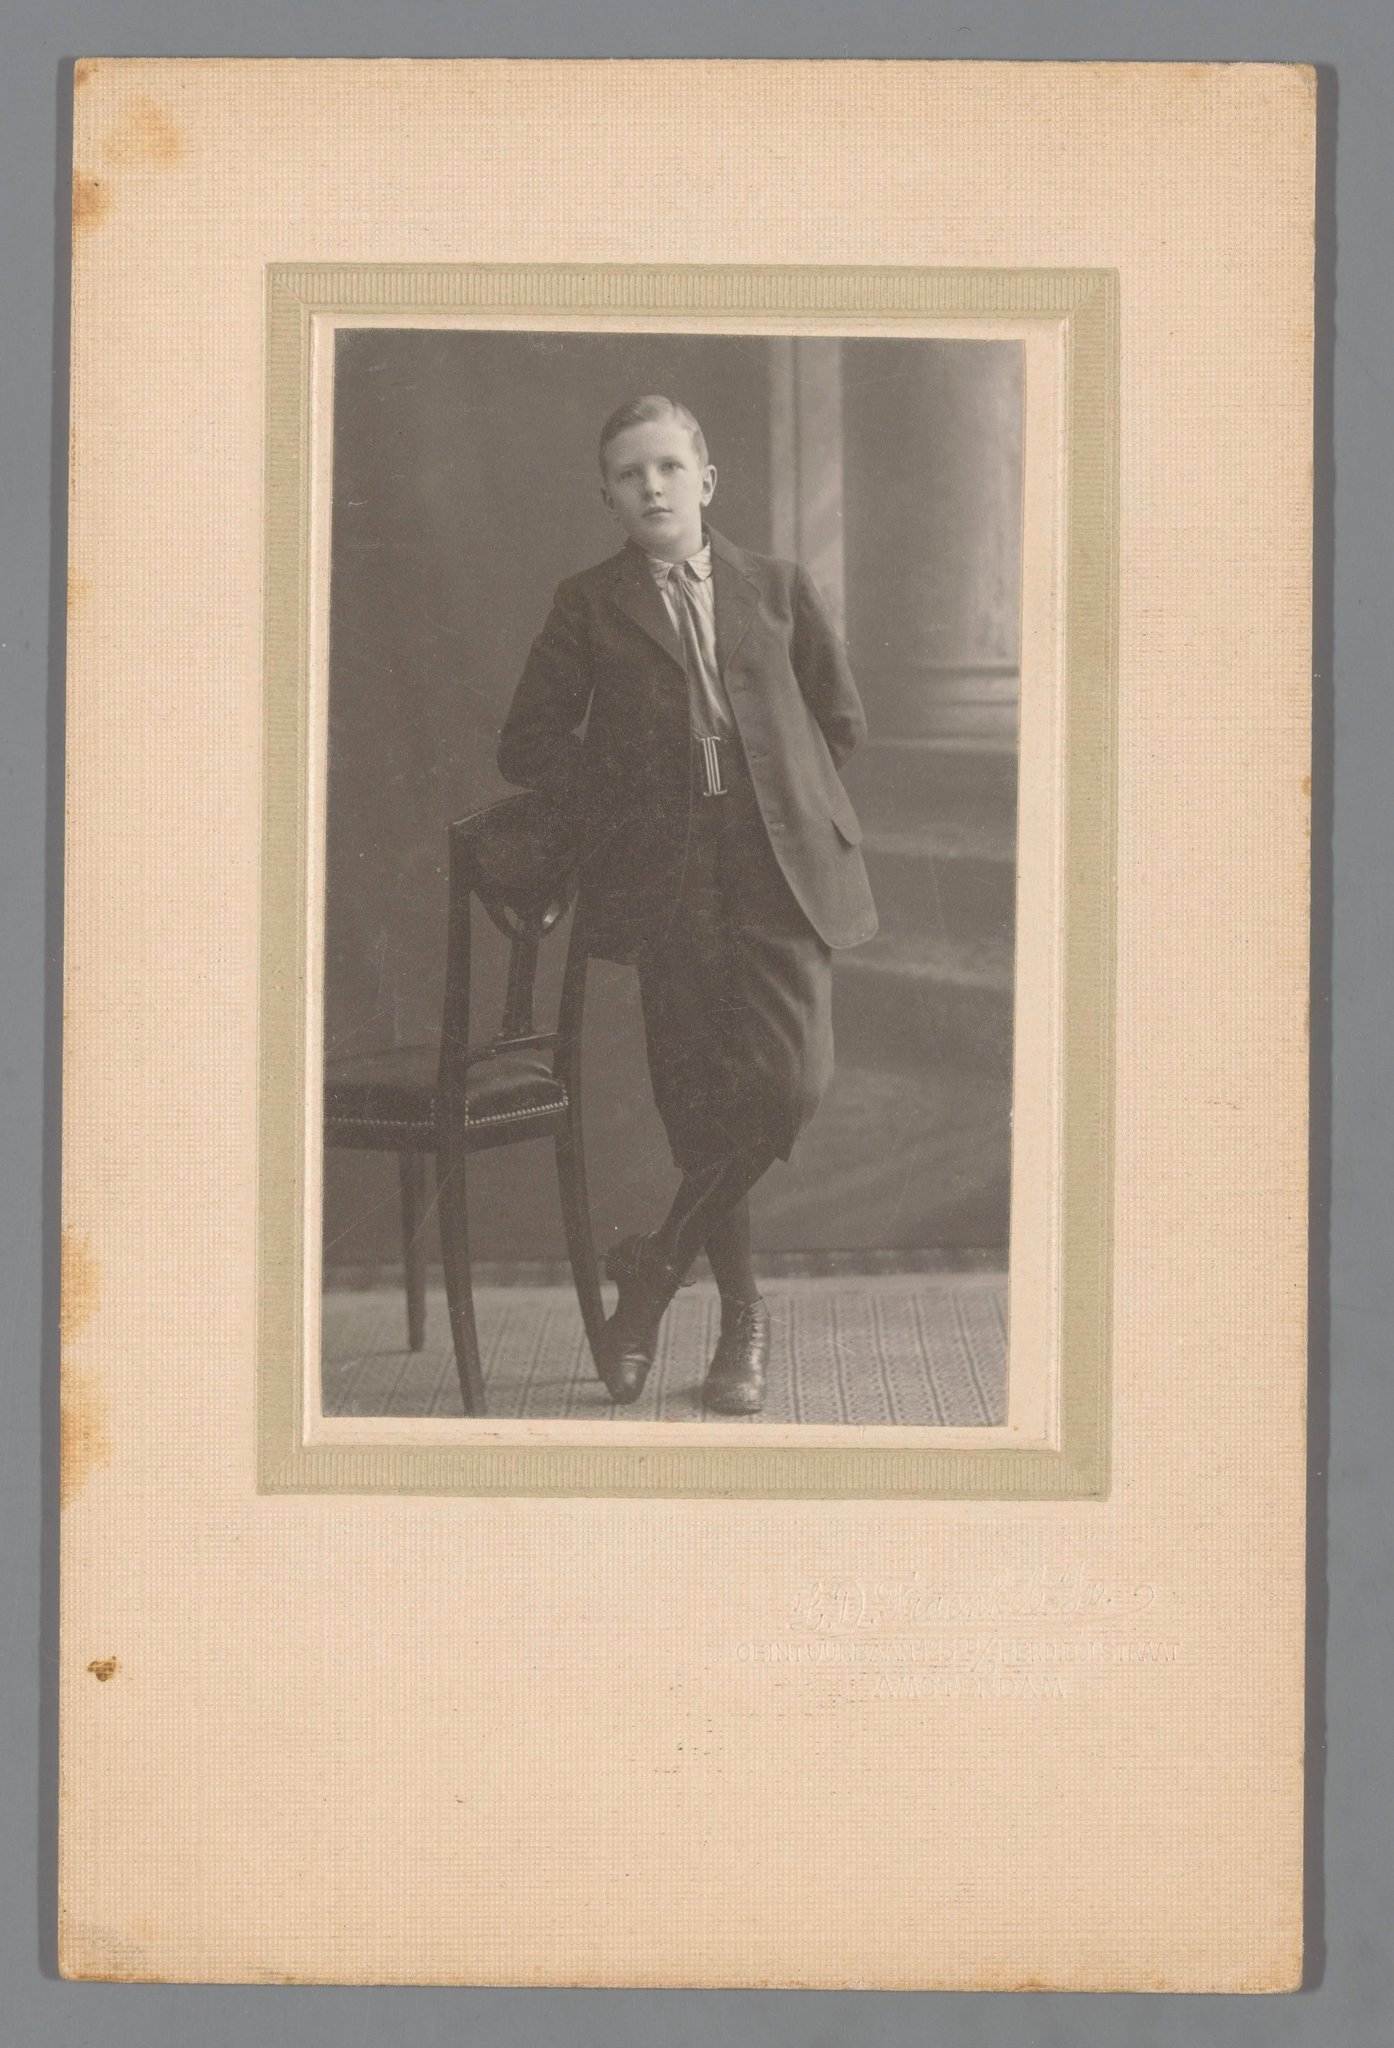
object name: cabinet photograph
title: Portret van A. de Roos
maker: zacharias fraenkel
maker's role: fotograaf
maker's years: 1878-1942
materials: cardboard, photographic support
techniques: gelatin silver print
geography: amsterdam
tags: studio requisites ~ photographer, boy (child between toddler and youth)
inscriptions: name: ‘Z.D. Fraenkel jr. Amsterdam Ceintuurbaan 123 b/d. Ferd. Bolstr.’, name: ‘A. de Roos zoon van Jac Roos en Neeltje Sinnema’